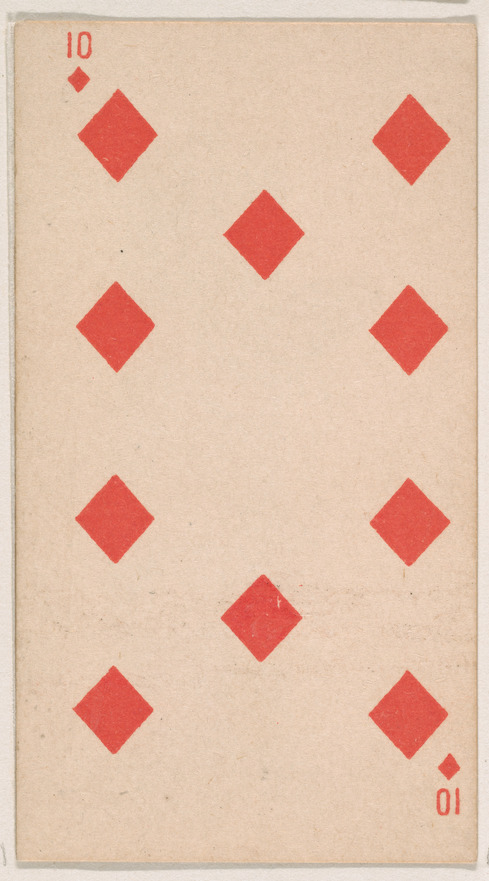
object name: print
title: Ten of Diamonds, from the Transparent Playing Cards series (N220) issued by Kinney Bros.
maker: kinney brothers tobacco company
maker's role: publisher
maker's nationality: american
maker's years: 1869-2011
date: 1888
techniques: color lithograph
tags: playing cards